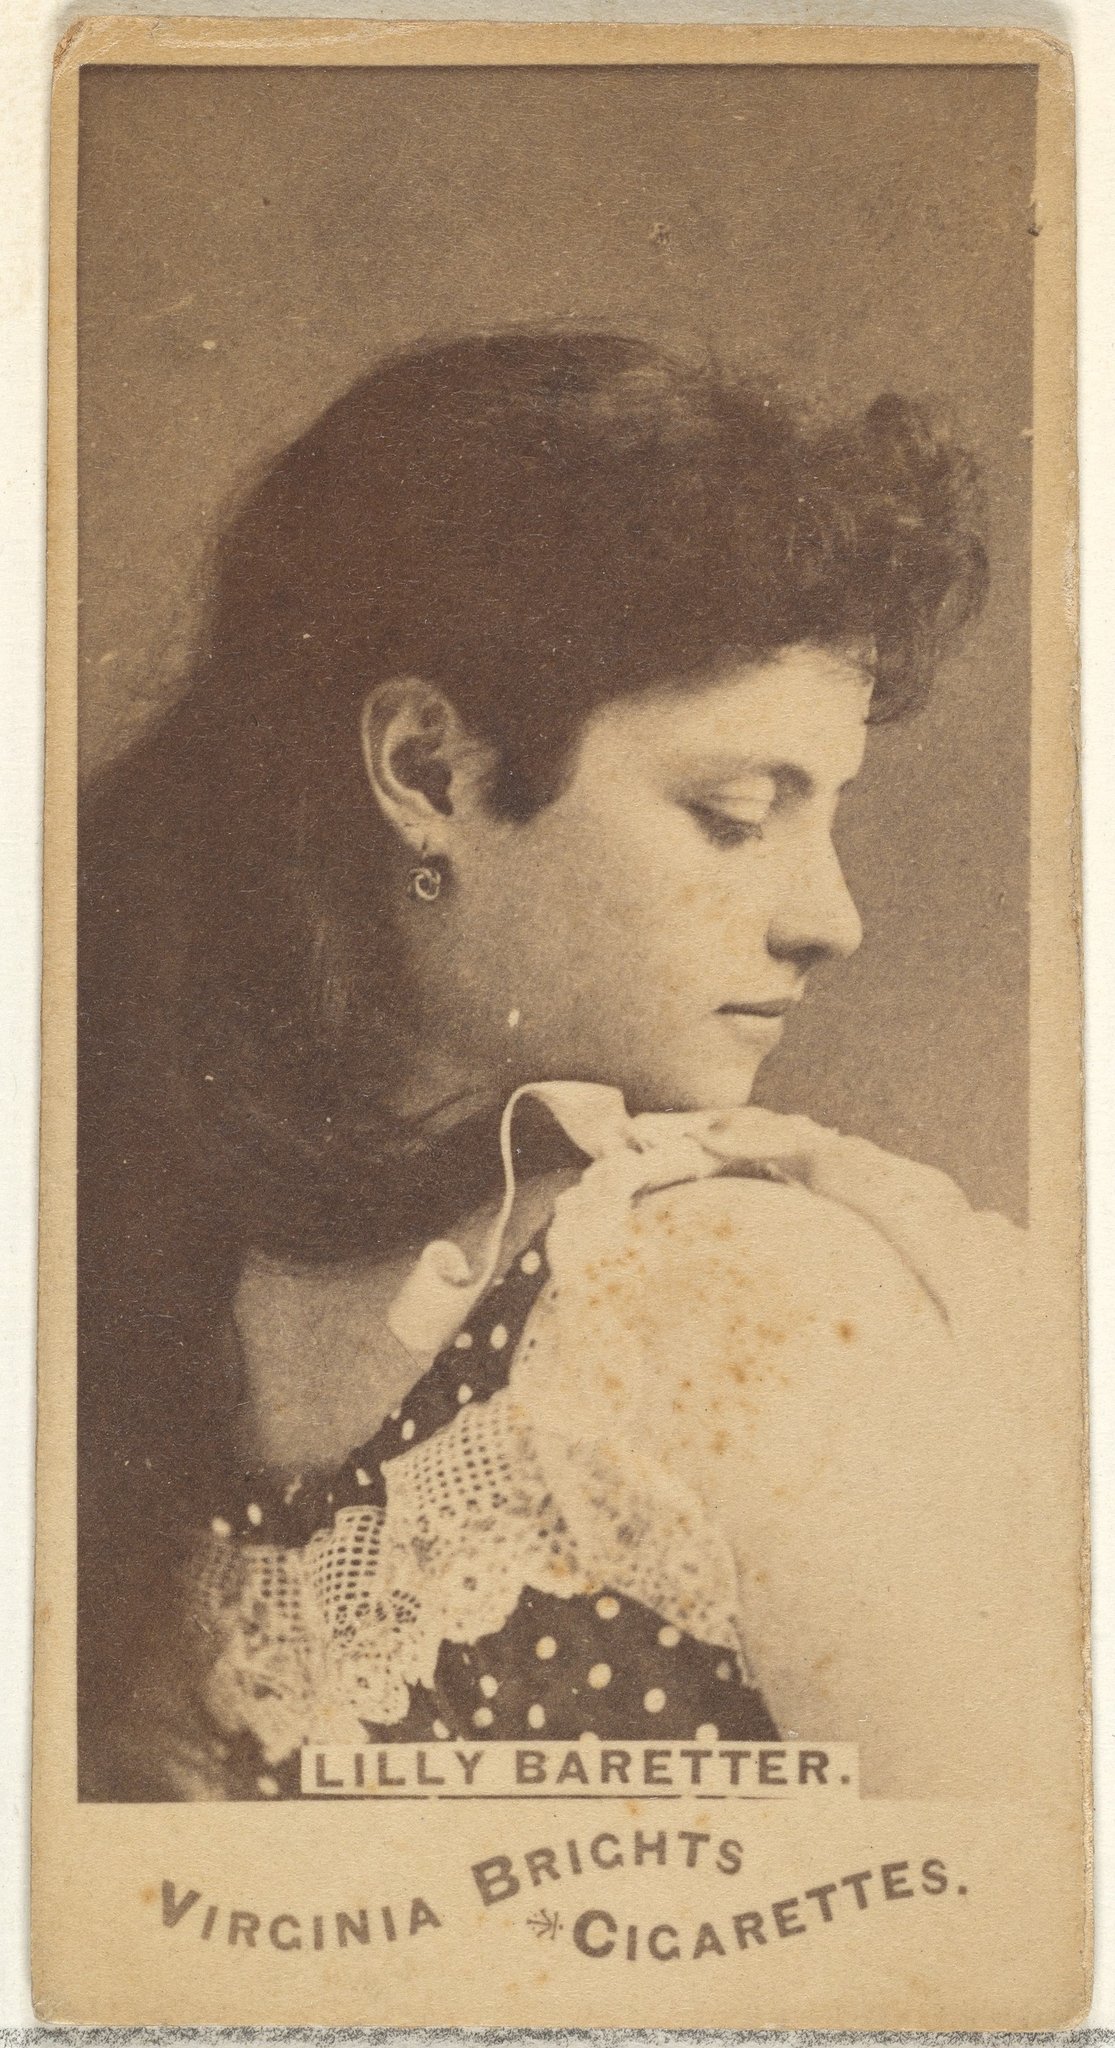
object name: photograph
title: Lilly Baretter, from the Actors and Actresses series (N45, Type 1) for Virginia Brights Cigarettes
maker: allen & ginter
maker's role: publisher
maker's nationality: american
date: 1888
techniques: albumen silver print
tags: portraits,profiles,women,actresses